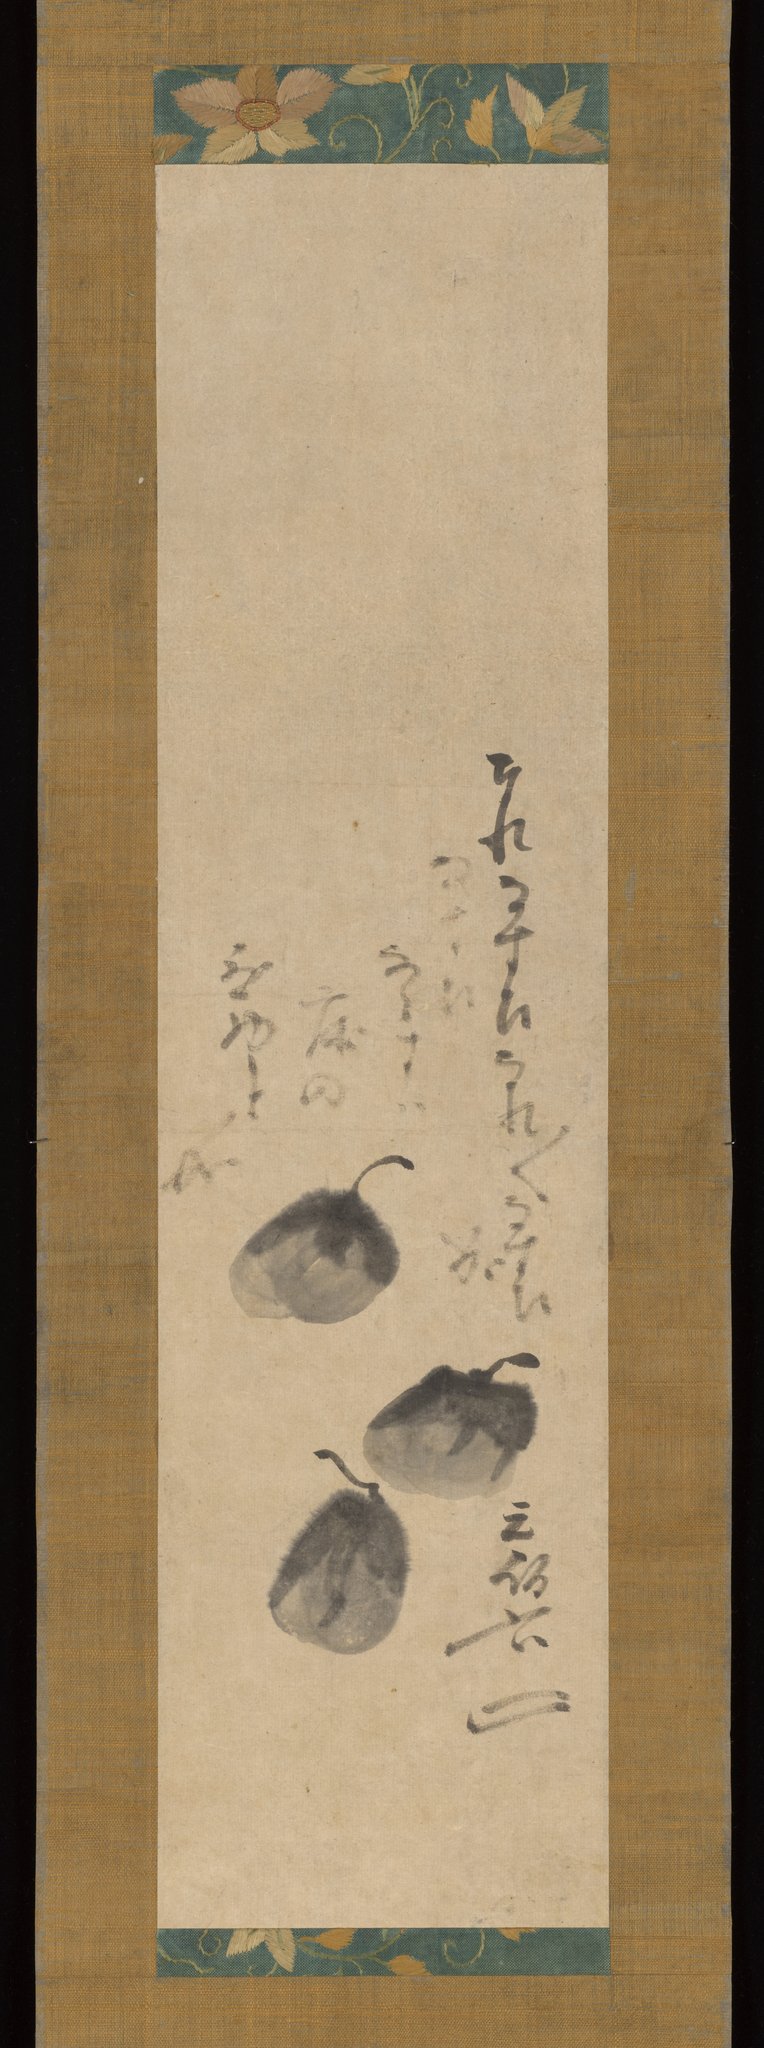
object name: hanging scroll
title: Three Eggplants and Poem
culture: japanese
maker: sen sōtan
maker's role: artist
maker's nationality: japanese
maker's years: 1578-1658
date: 1601-1700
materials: ink, paper